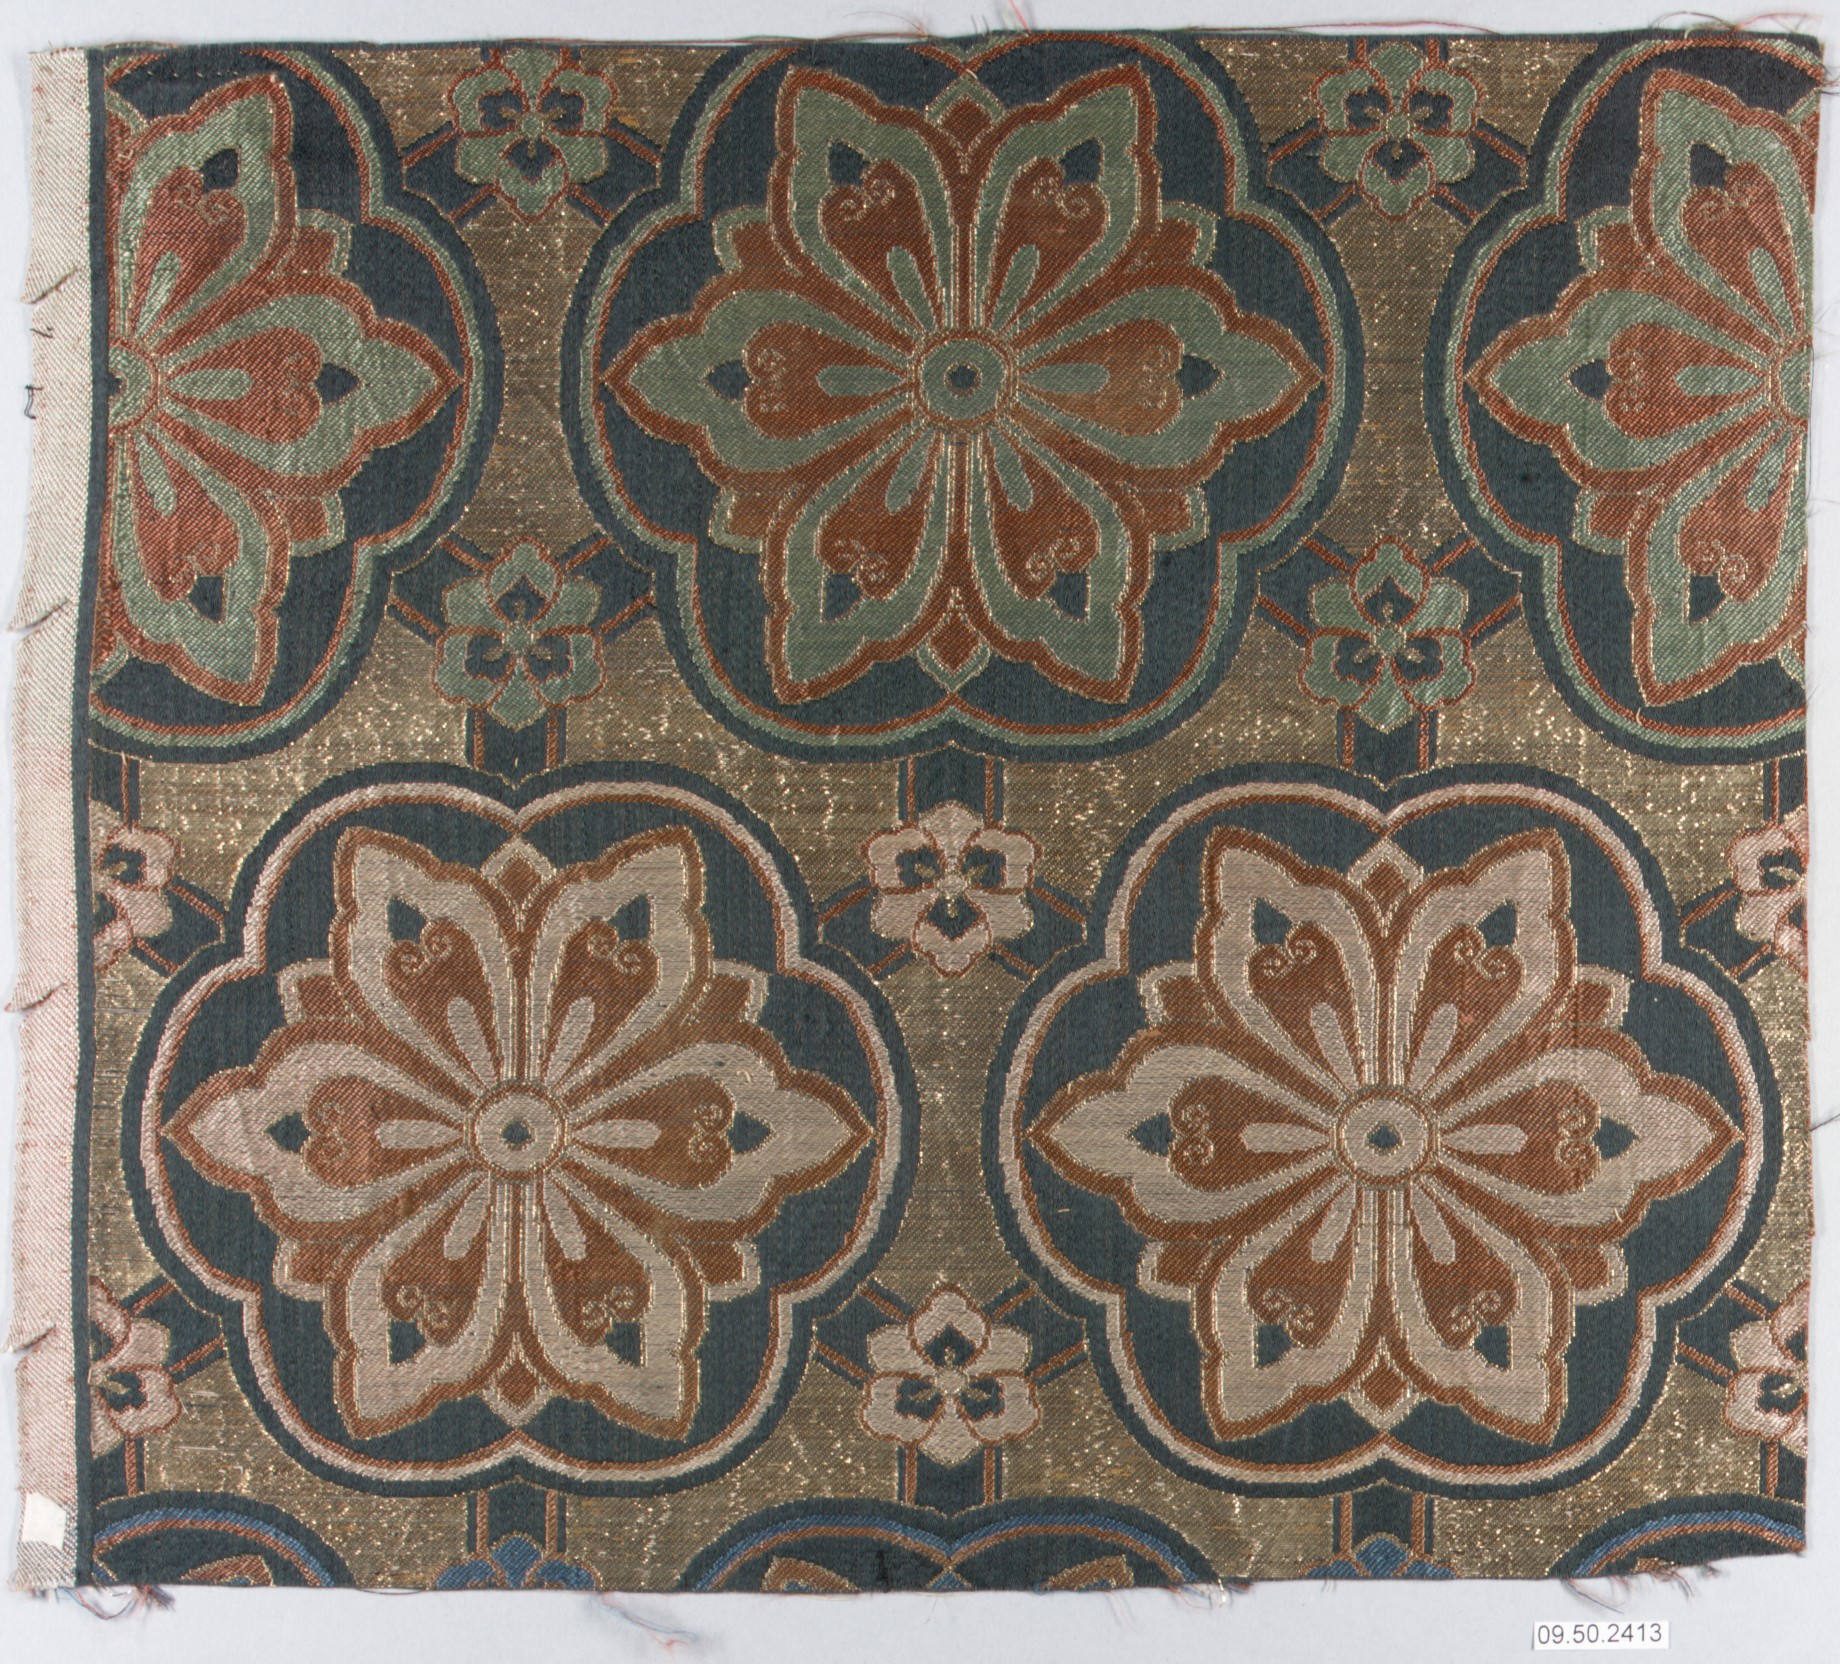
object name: piece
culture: japanese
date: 1701-1800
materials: metal thread, silk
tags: flowers